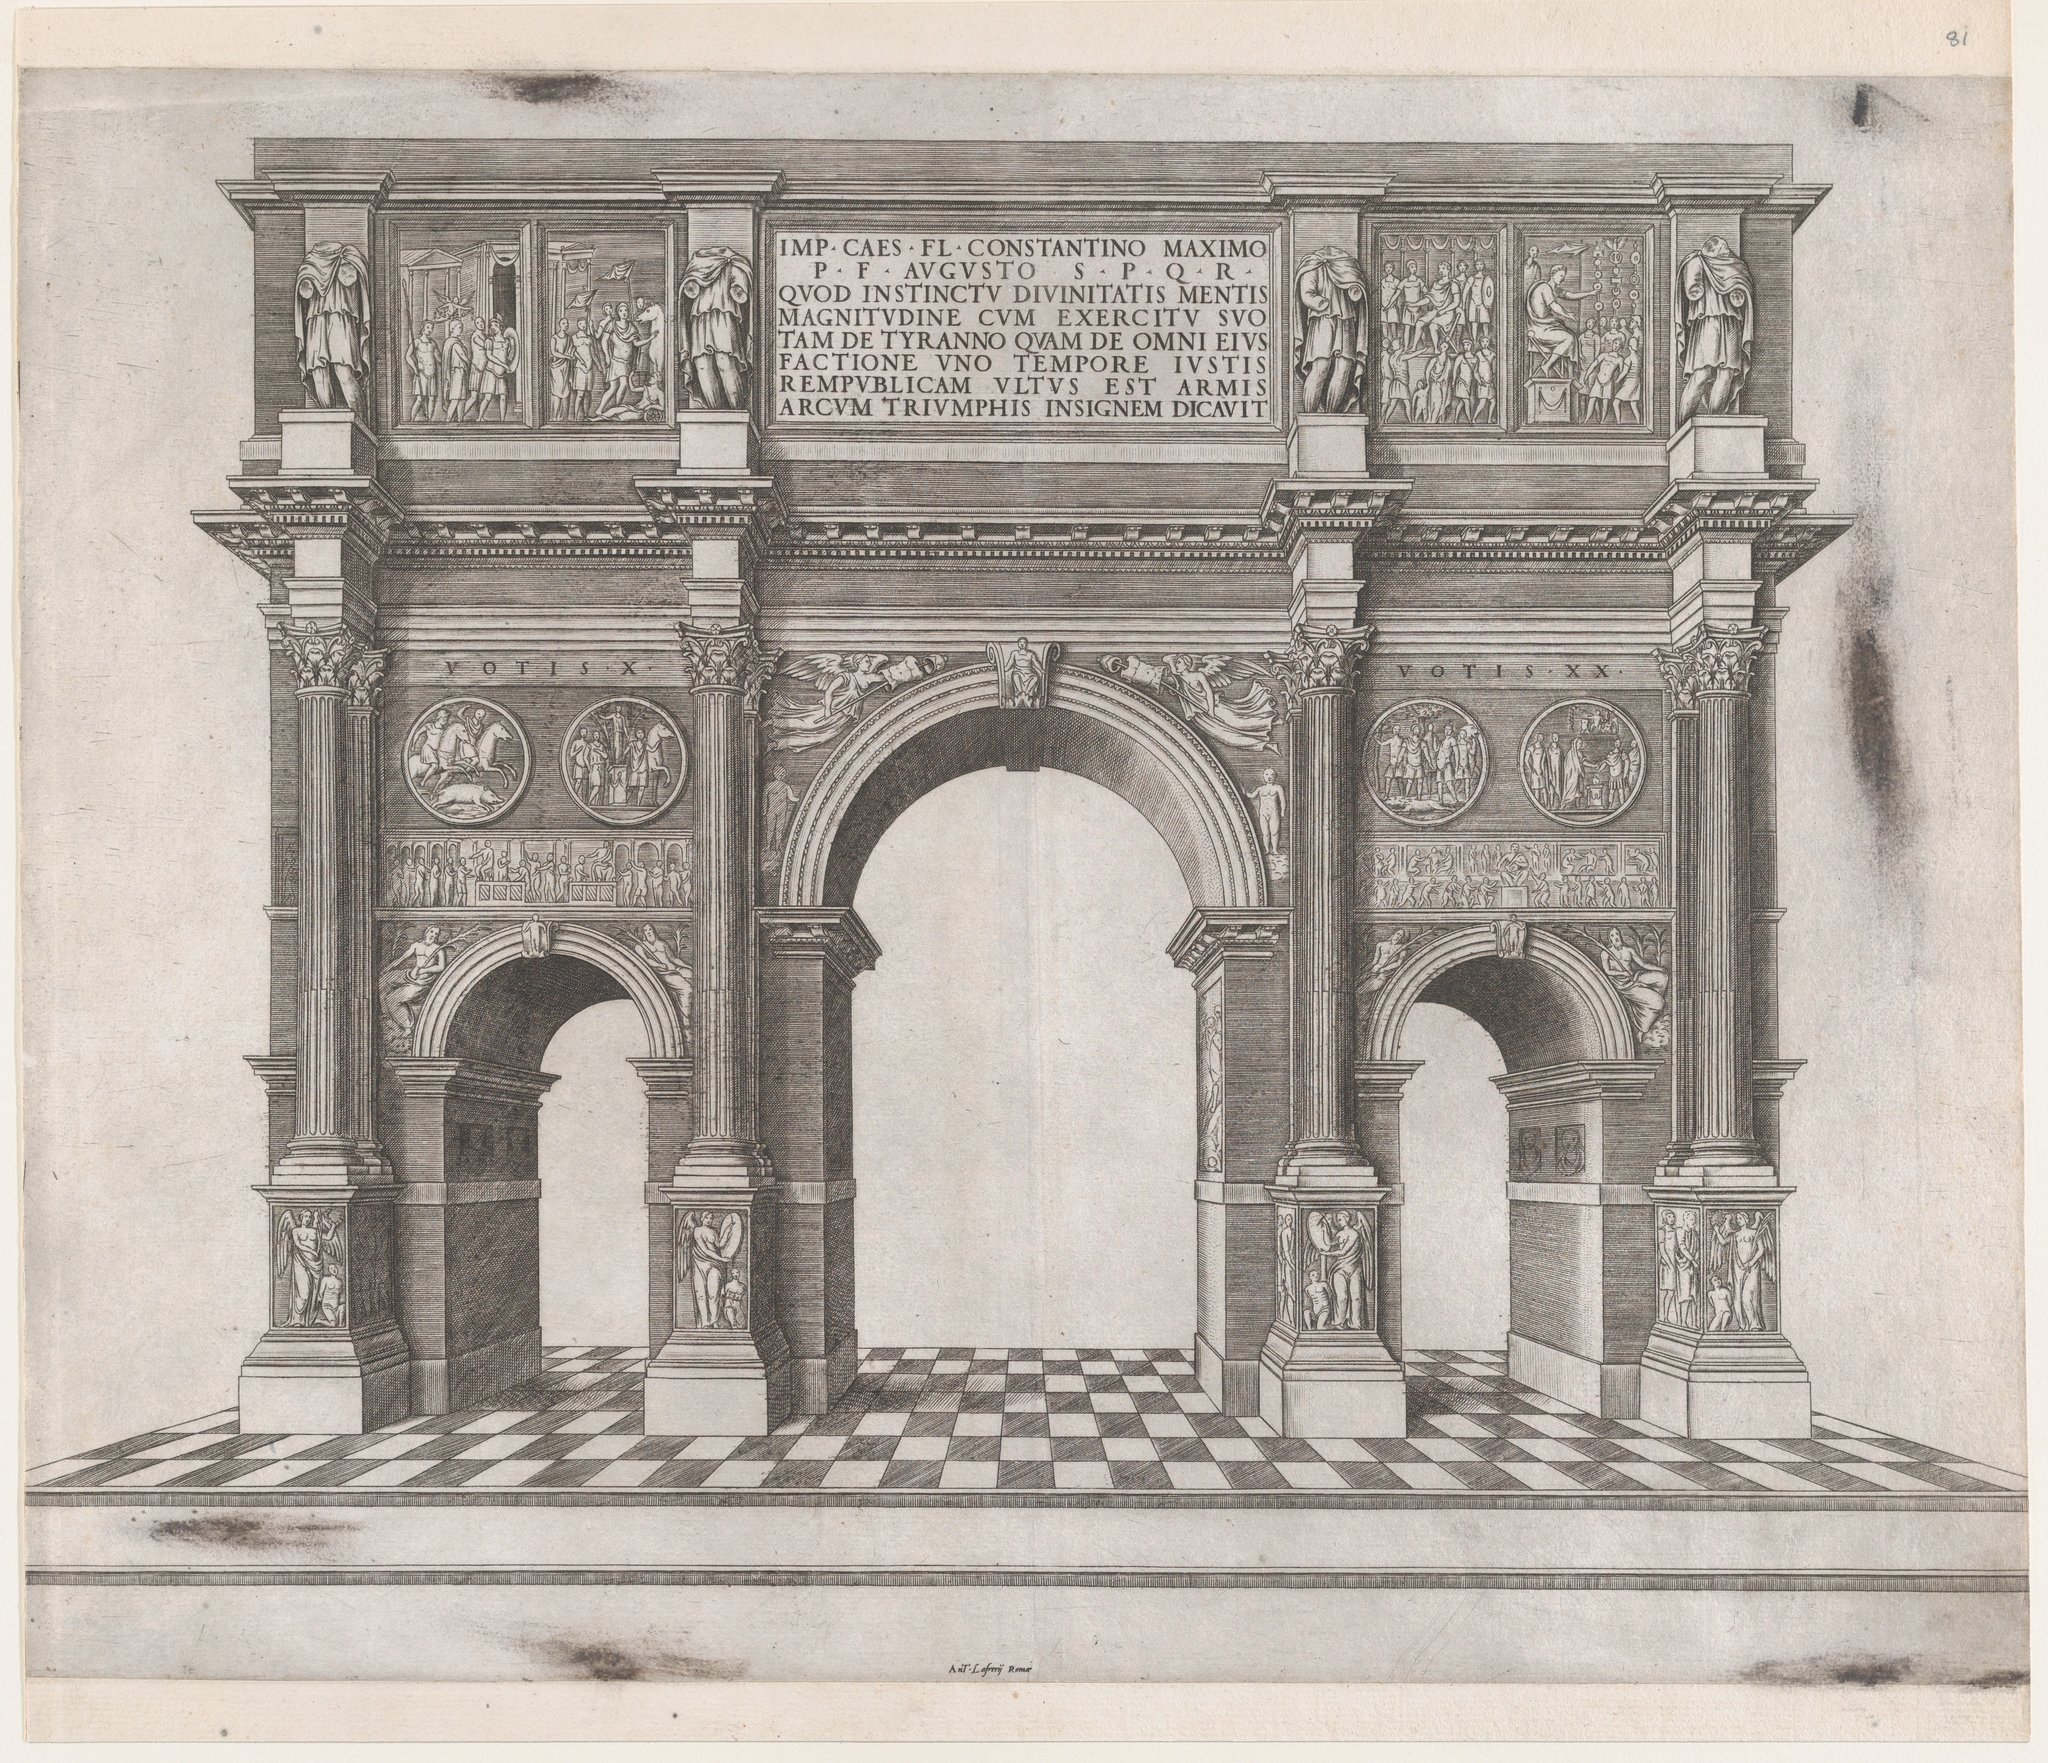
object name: print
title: Arch of Constantine, from "Speculum Romanae Magnificentiae"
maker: Anonymous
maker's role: artist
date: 1501-1600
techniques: engraving, etching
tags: architecture,arches,rome